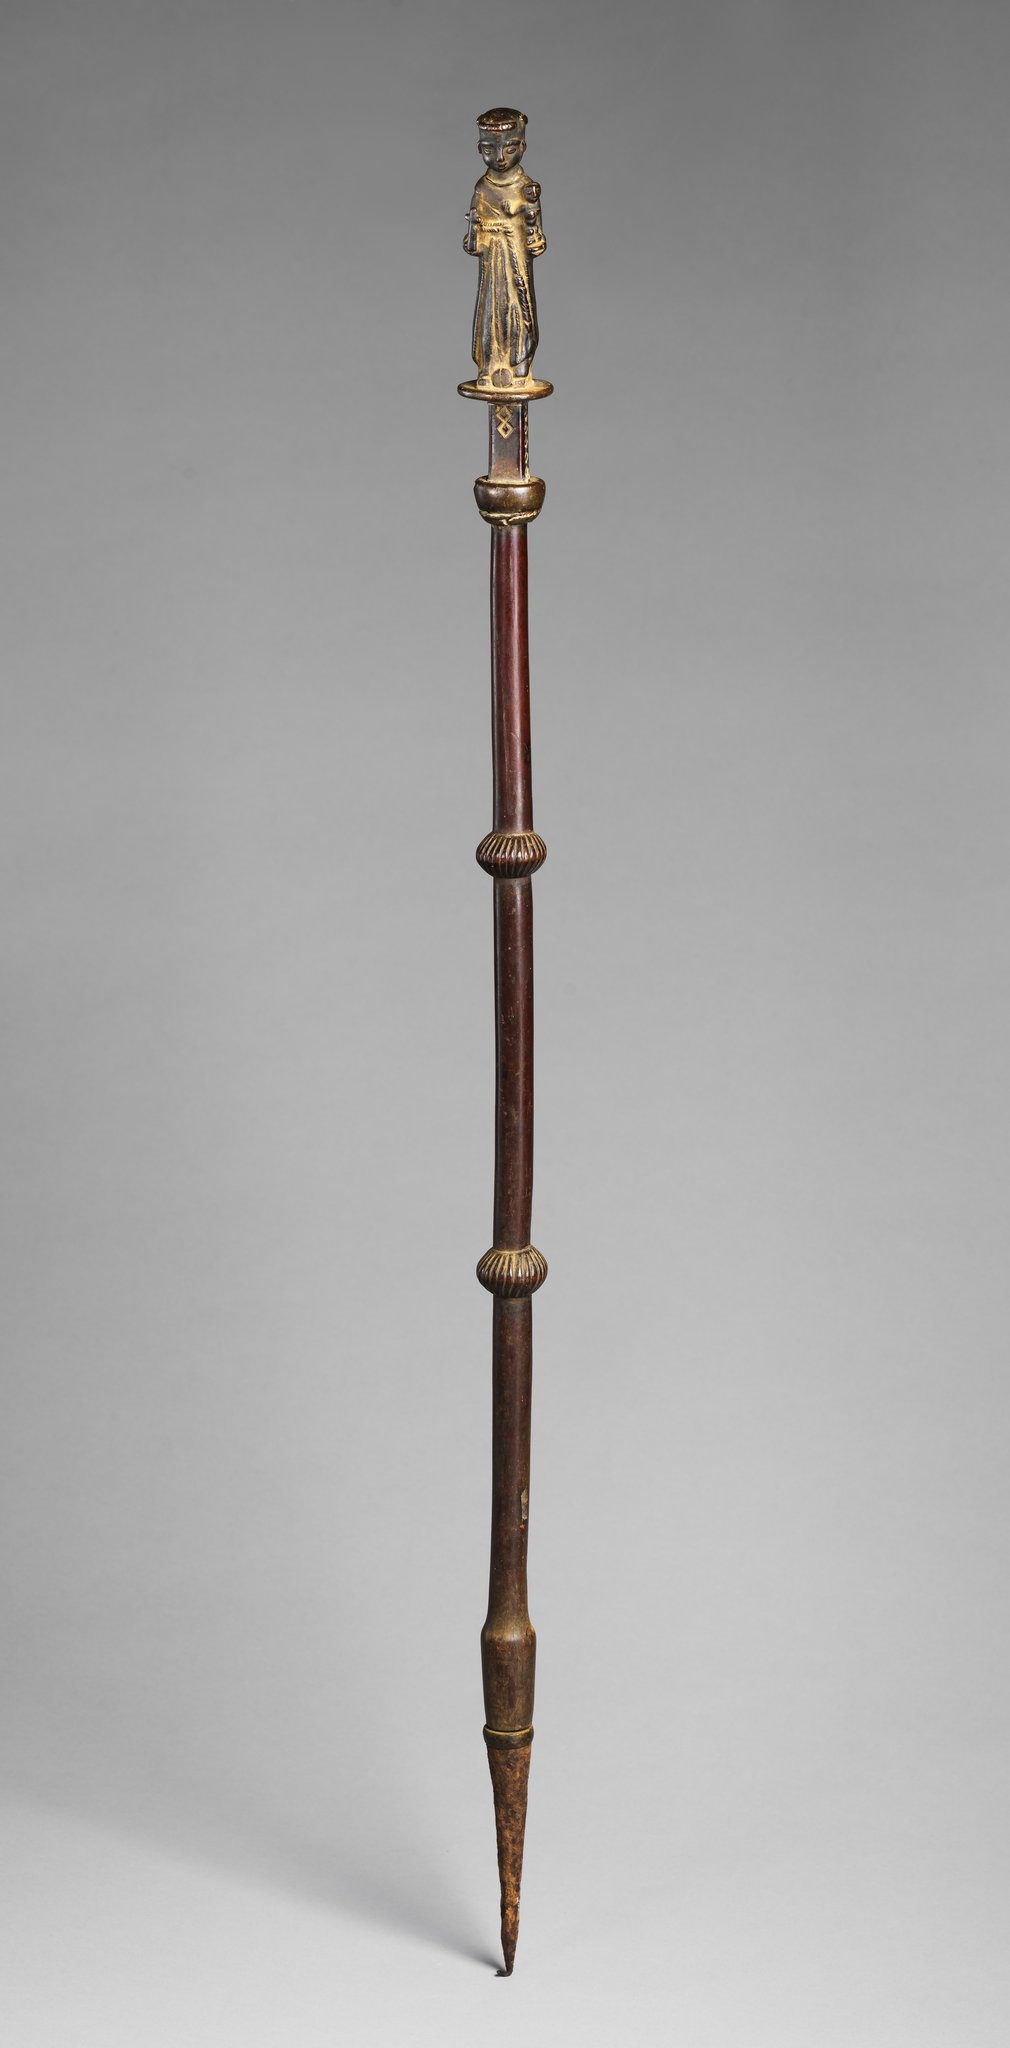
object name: staff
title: Staff with Saint Anthony of Padua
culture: kongo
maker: kongo artist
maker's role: artist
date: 1801-1900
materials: brass, iron, wood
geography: angola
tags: men,saint anthony